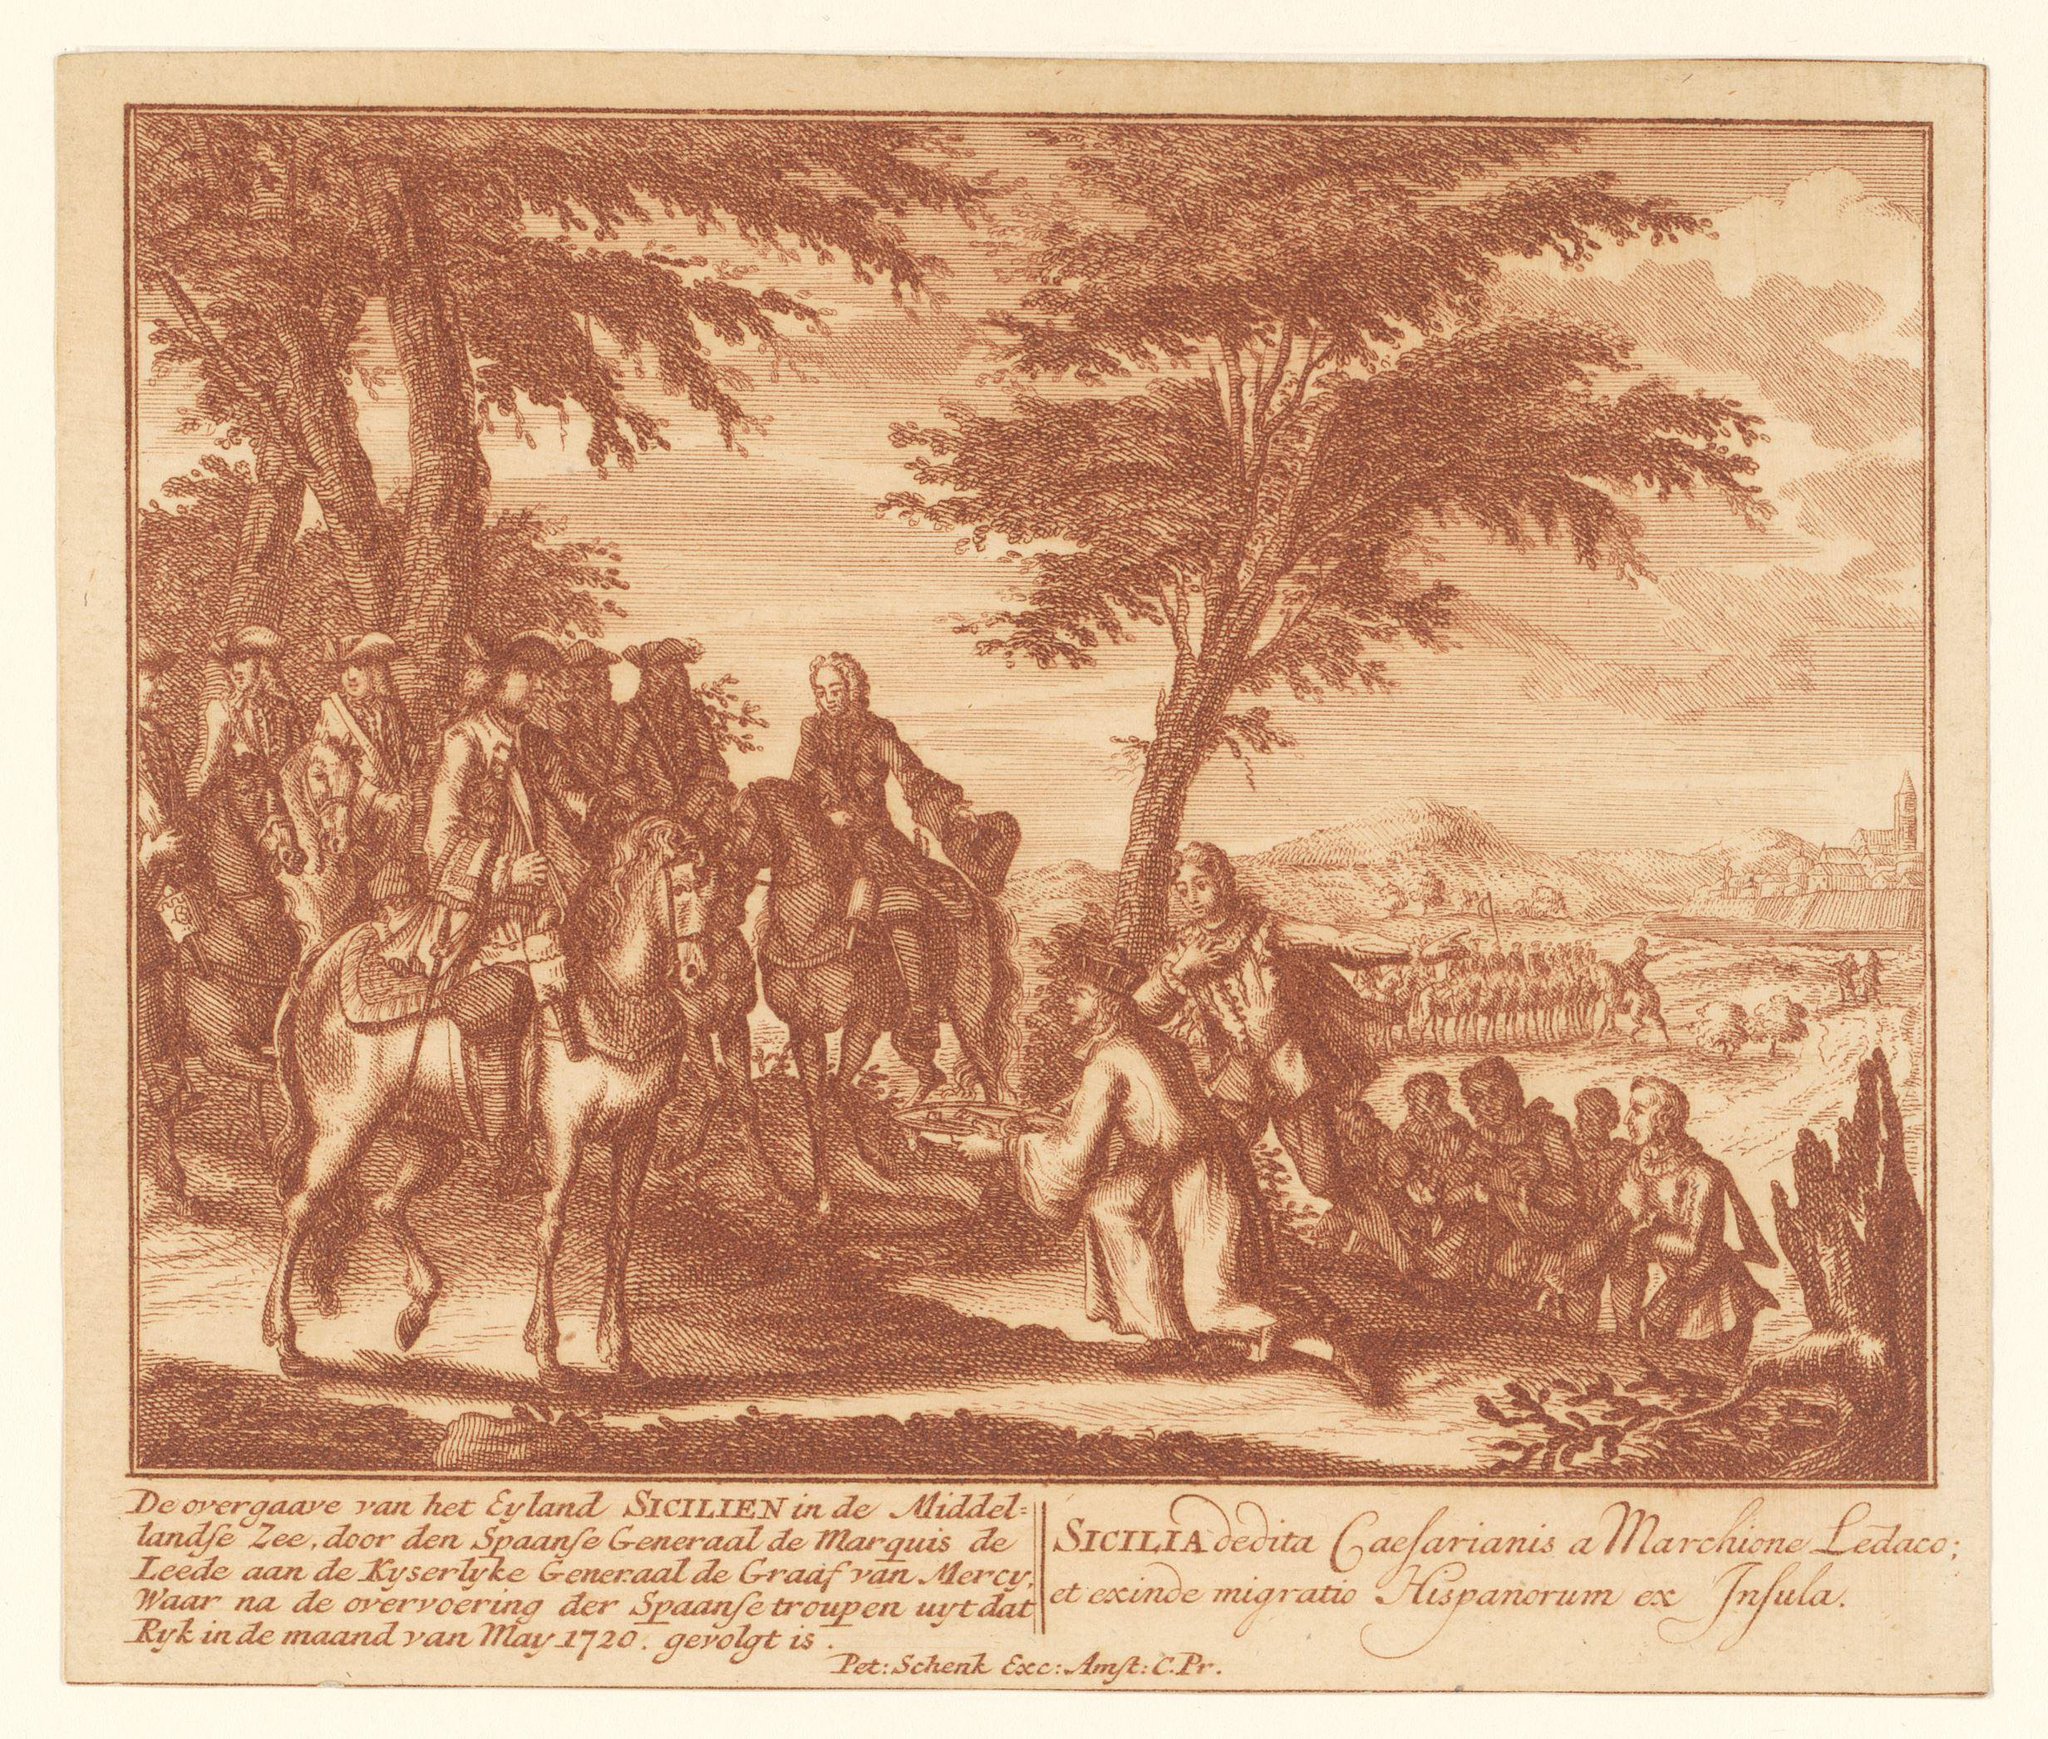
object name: print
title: Overgave van Sicilië door de Spanjaarden aan de Fransen, mei 1720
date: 1720-1722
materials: paper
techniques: etching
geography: amsterdam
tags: kneeling figure, surrender ~ war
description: De Spaanse generaal Markies de Leede geknield op de grond voor de keizerlijke graaf van Mercy te paard: de overgave van het eiland Sicilië, mei 1720. Met onderschrift in het Nederlands en Latijn.